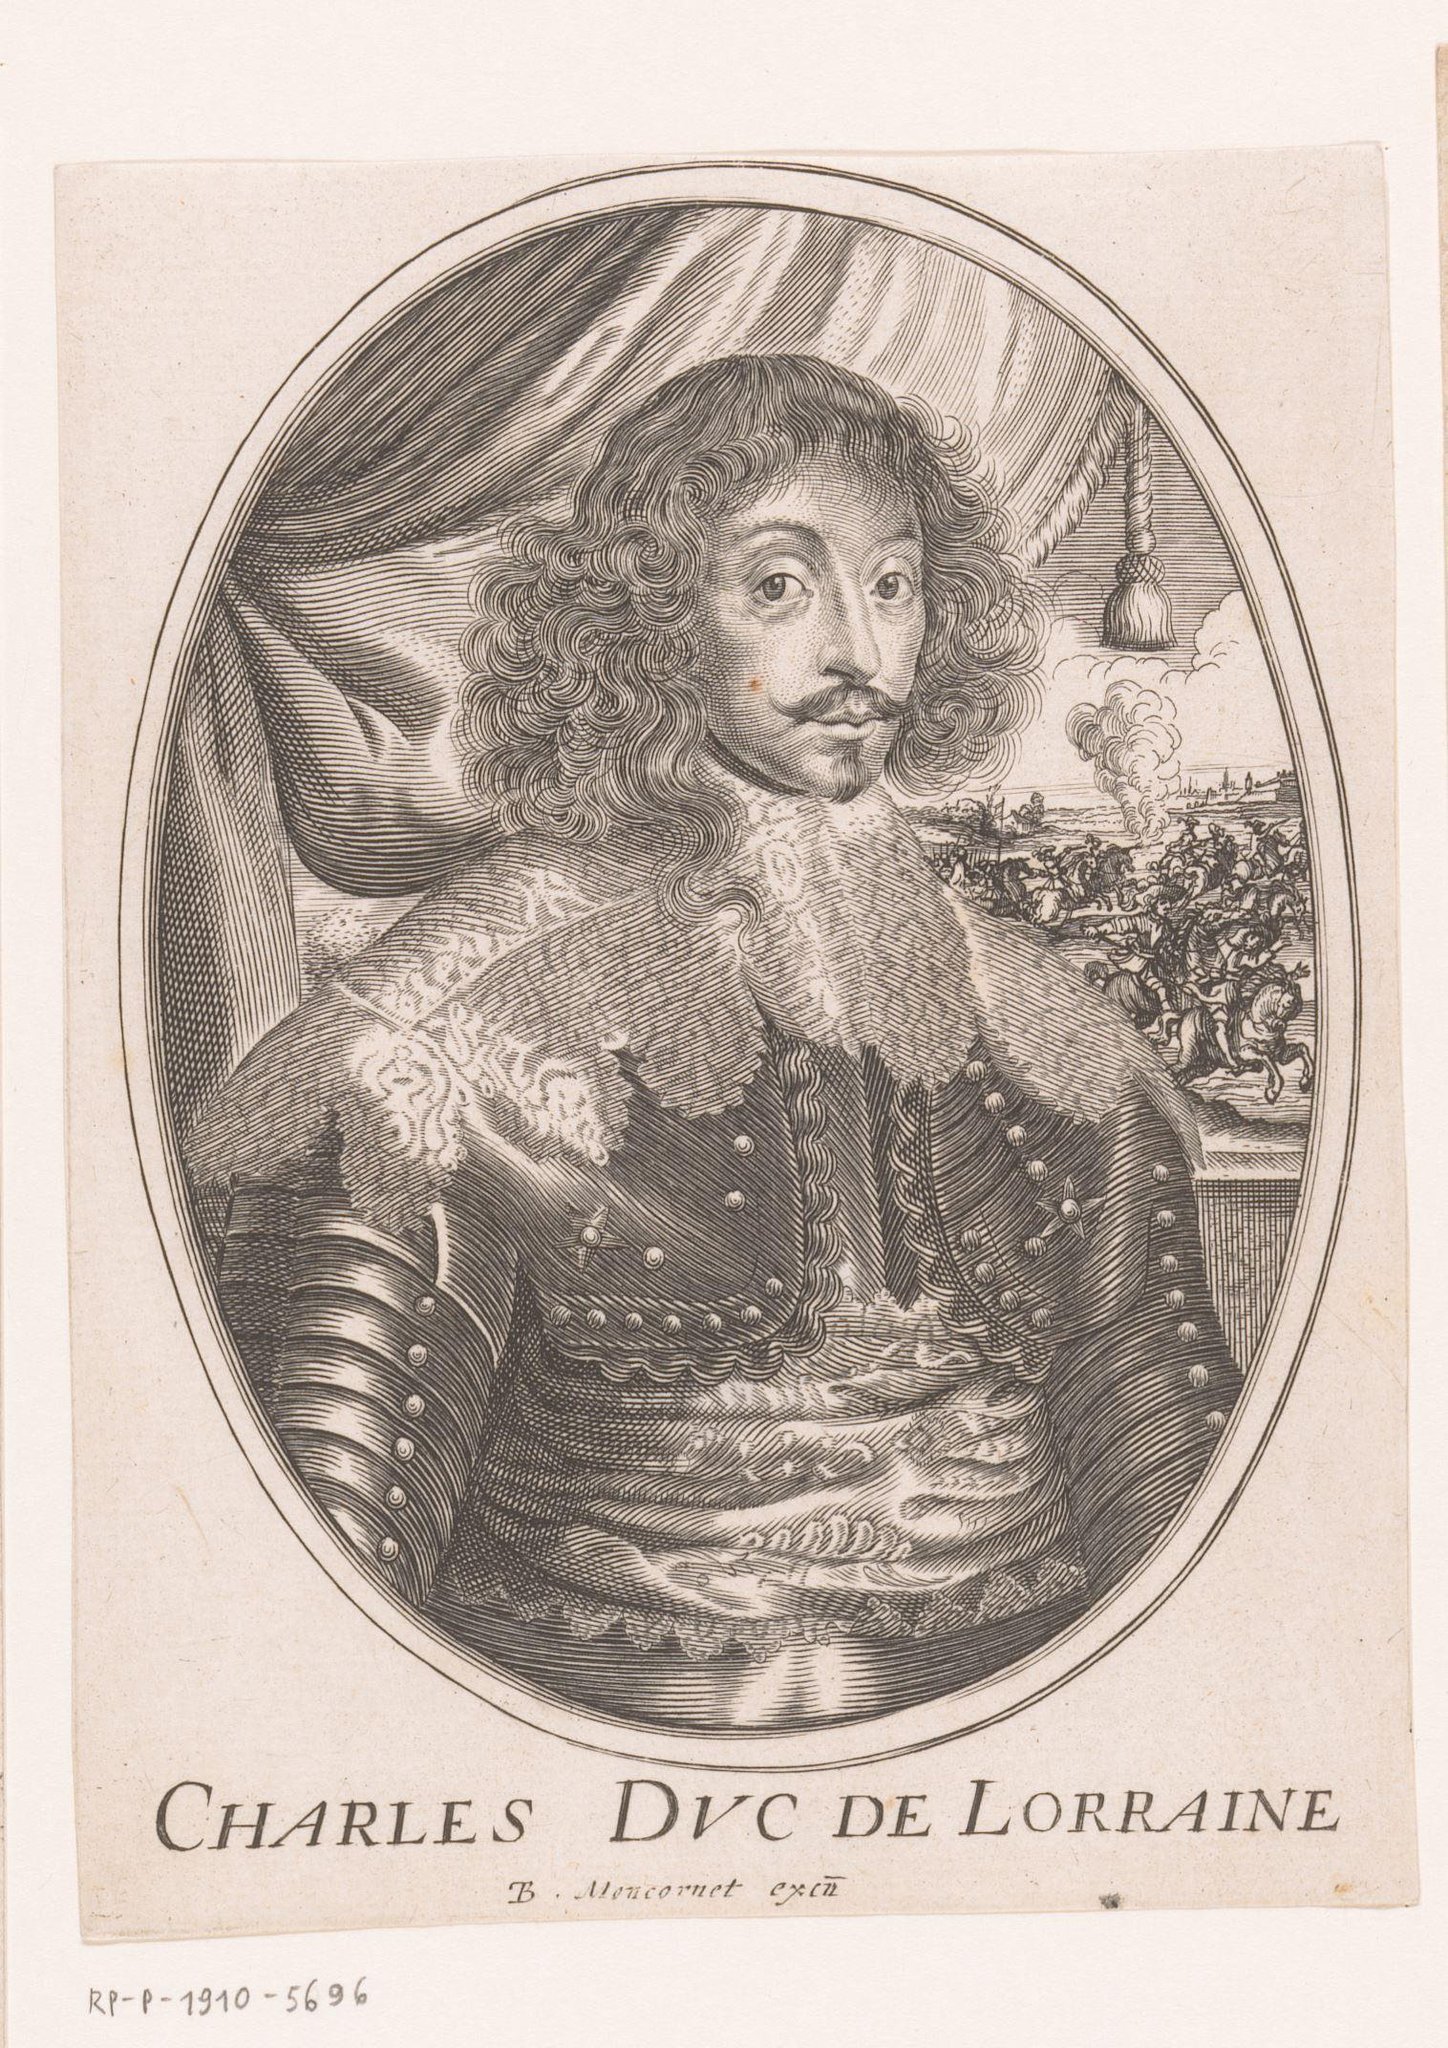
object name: print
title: Portret van Karel IV van Lotharingen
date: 1625-1668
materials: paper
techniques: engraving, etching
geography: france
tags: karel iv hertog van lotharingen, historical persons, nobility and patriciate; chivalry, knighthood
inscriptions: collector's mark: Lugt 2228